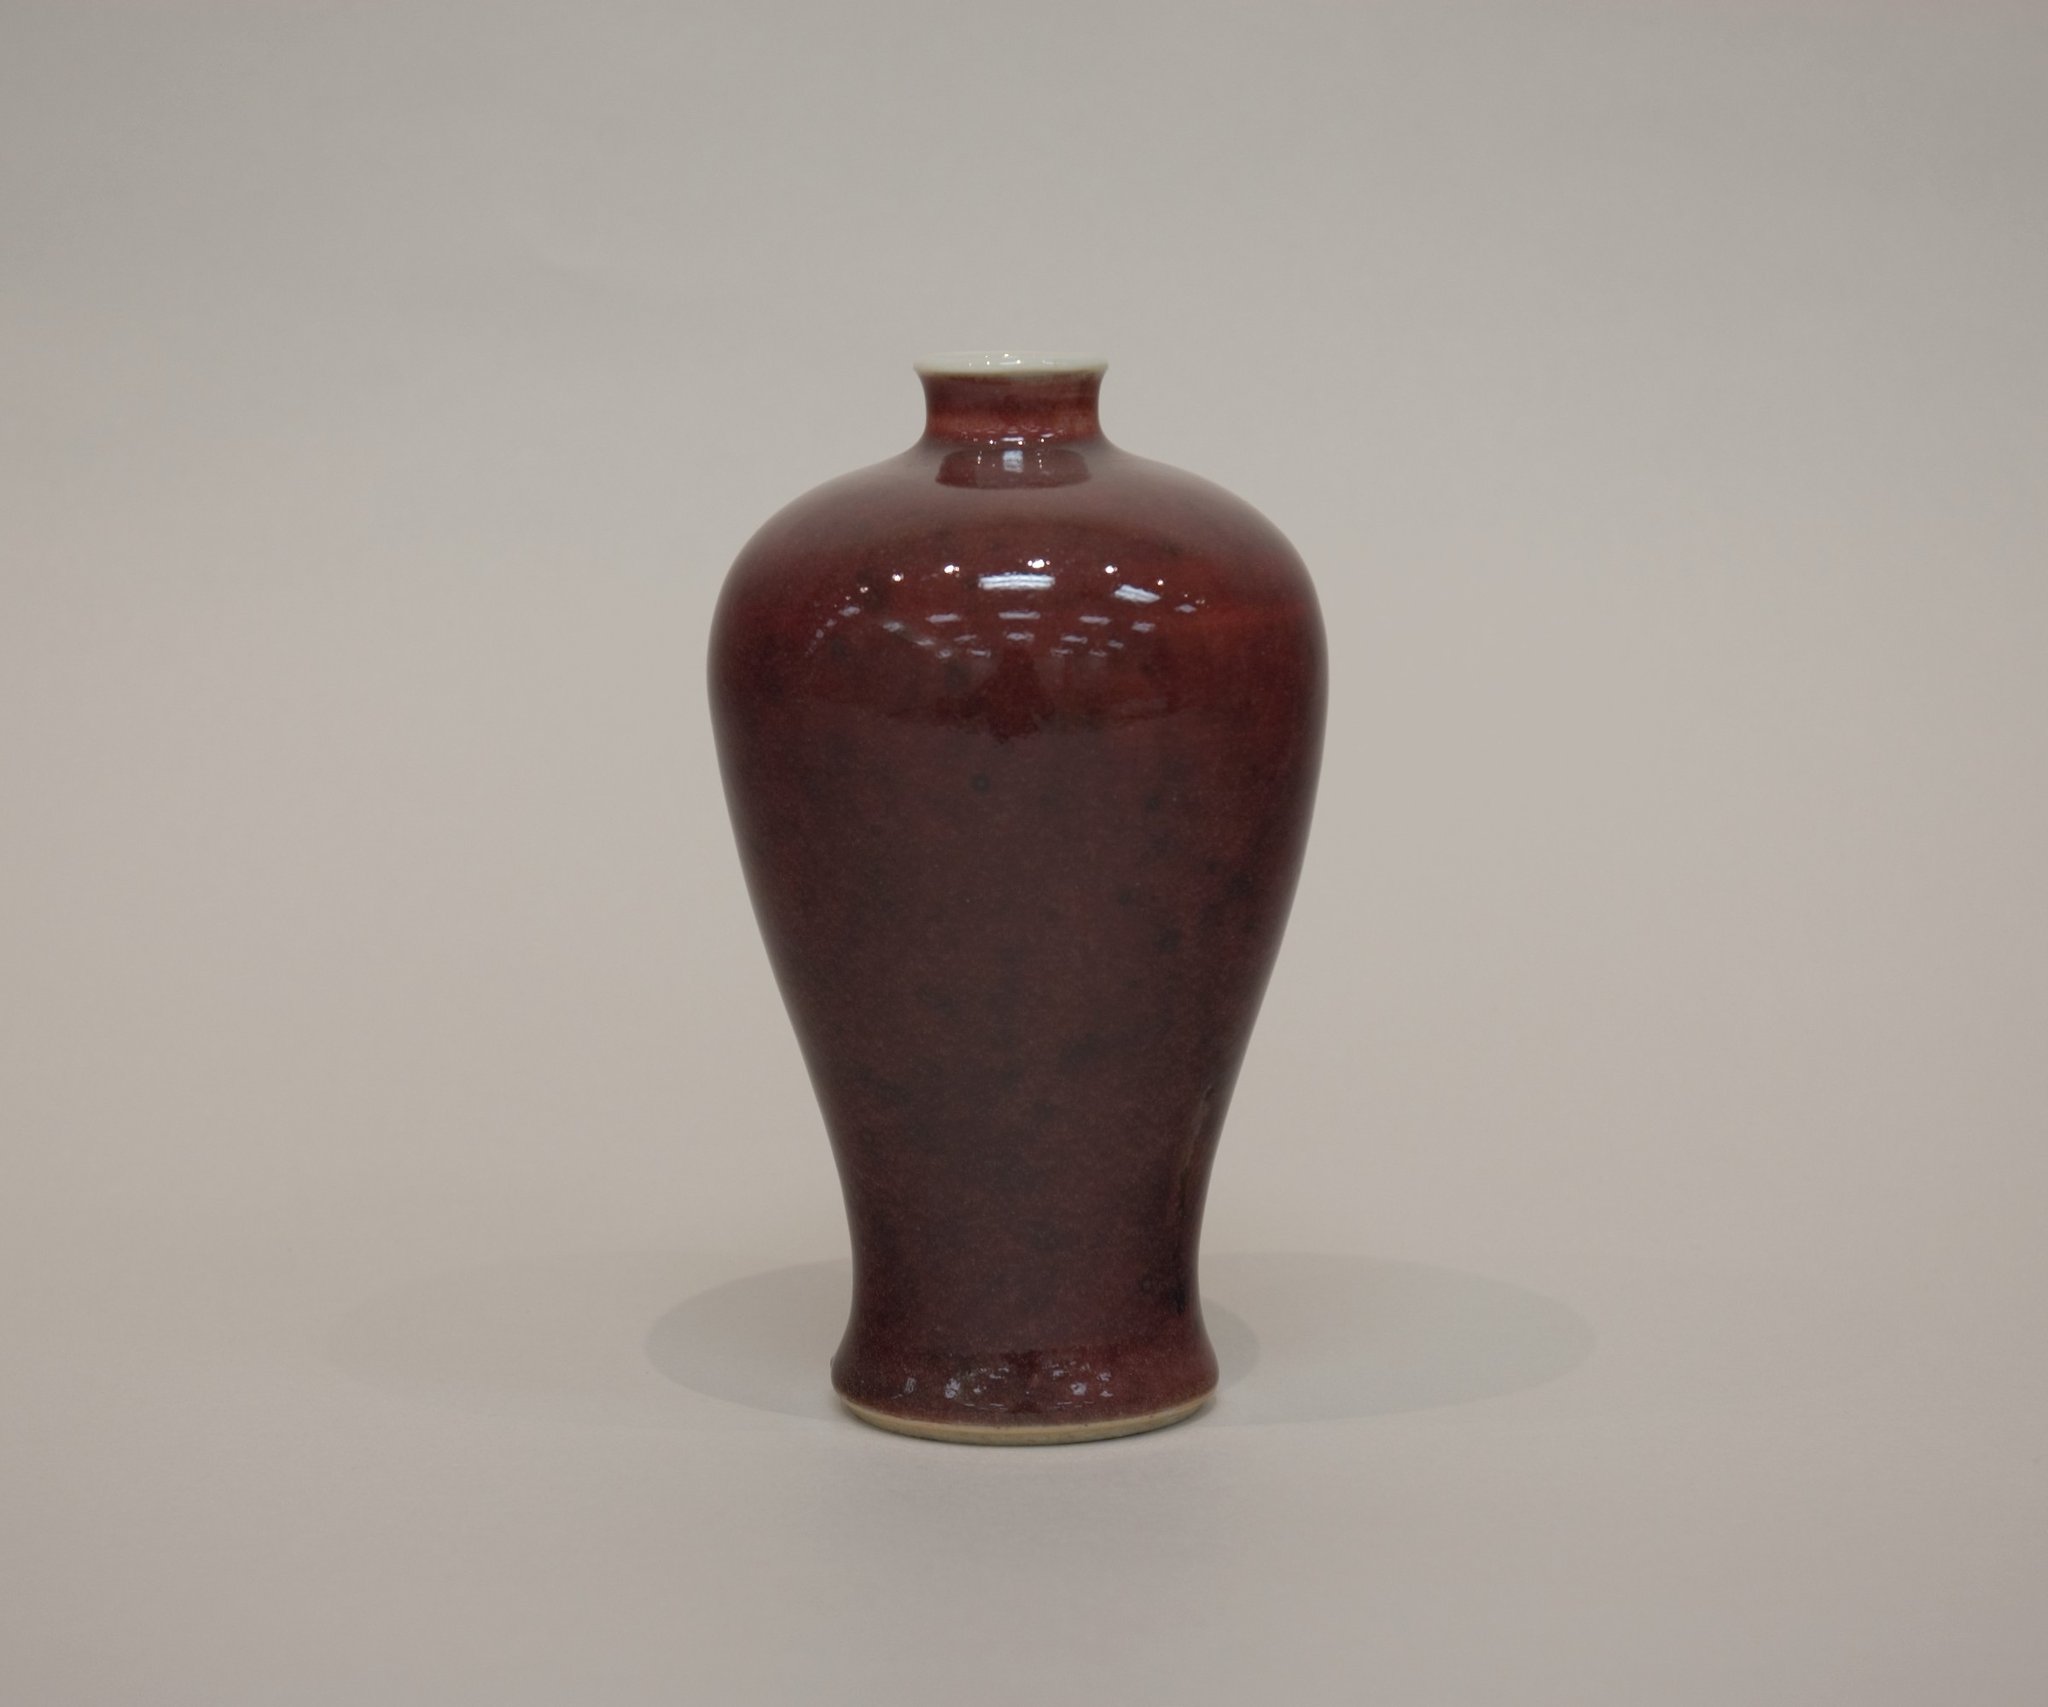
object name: vase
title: Meiping vase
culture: chinese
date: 1667-1733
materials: copper, glaze, porcelain